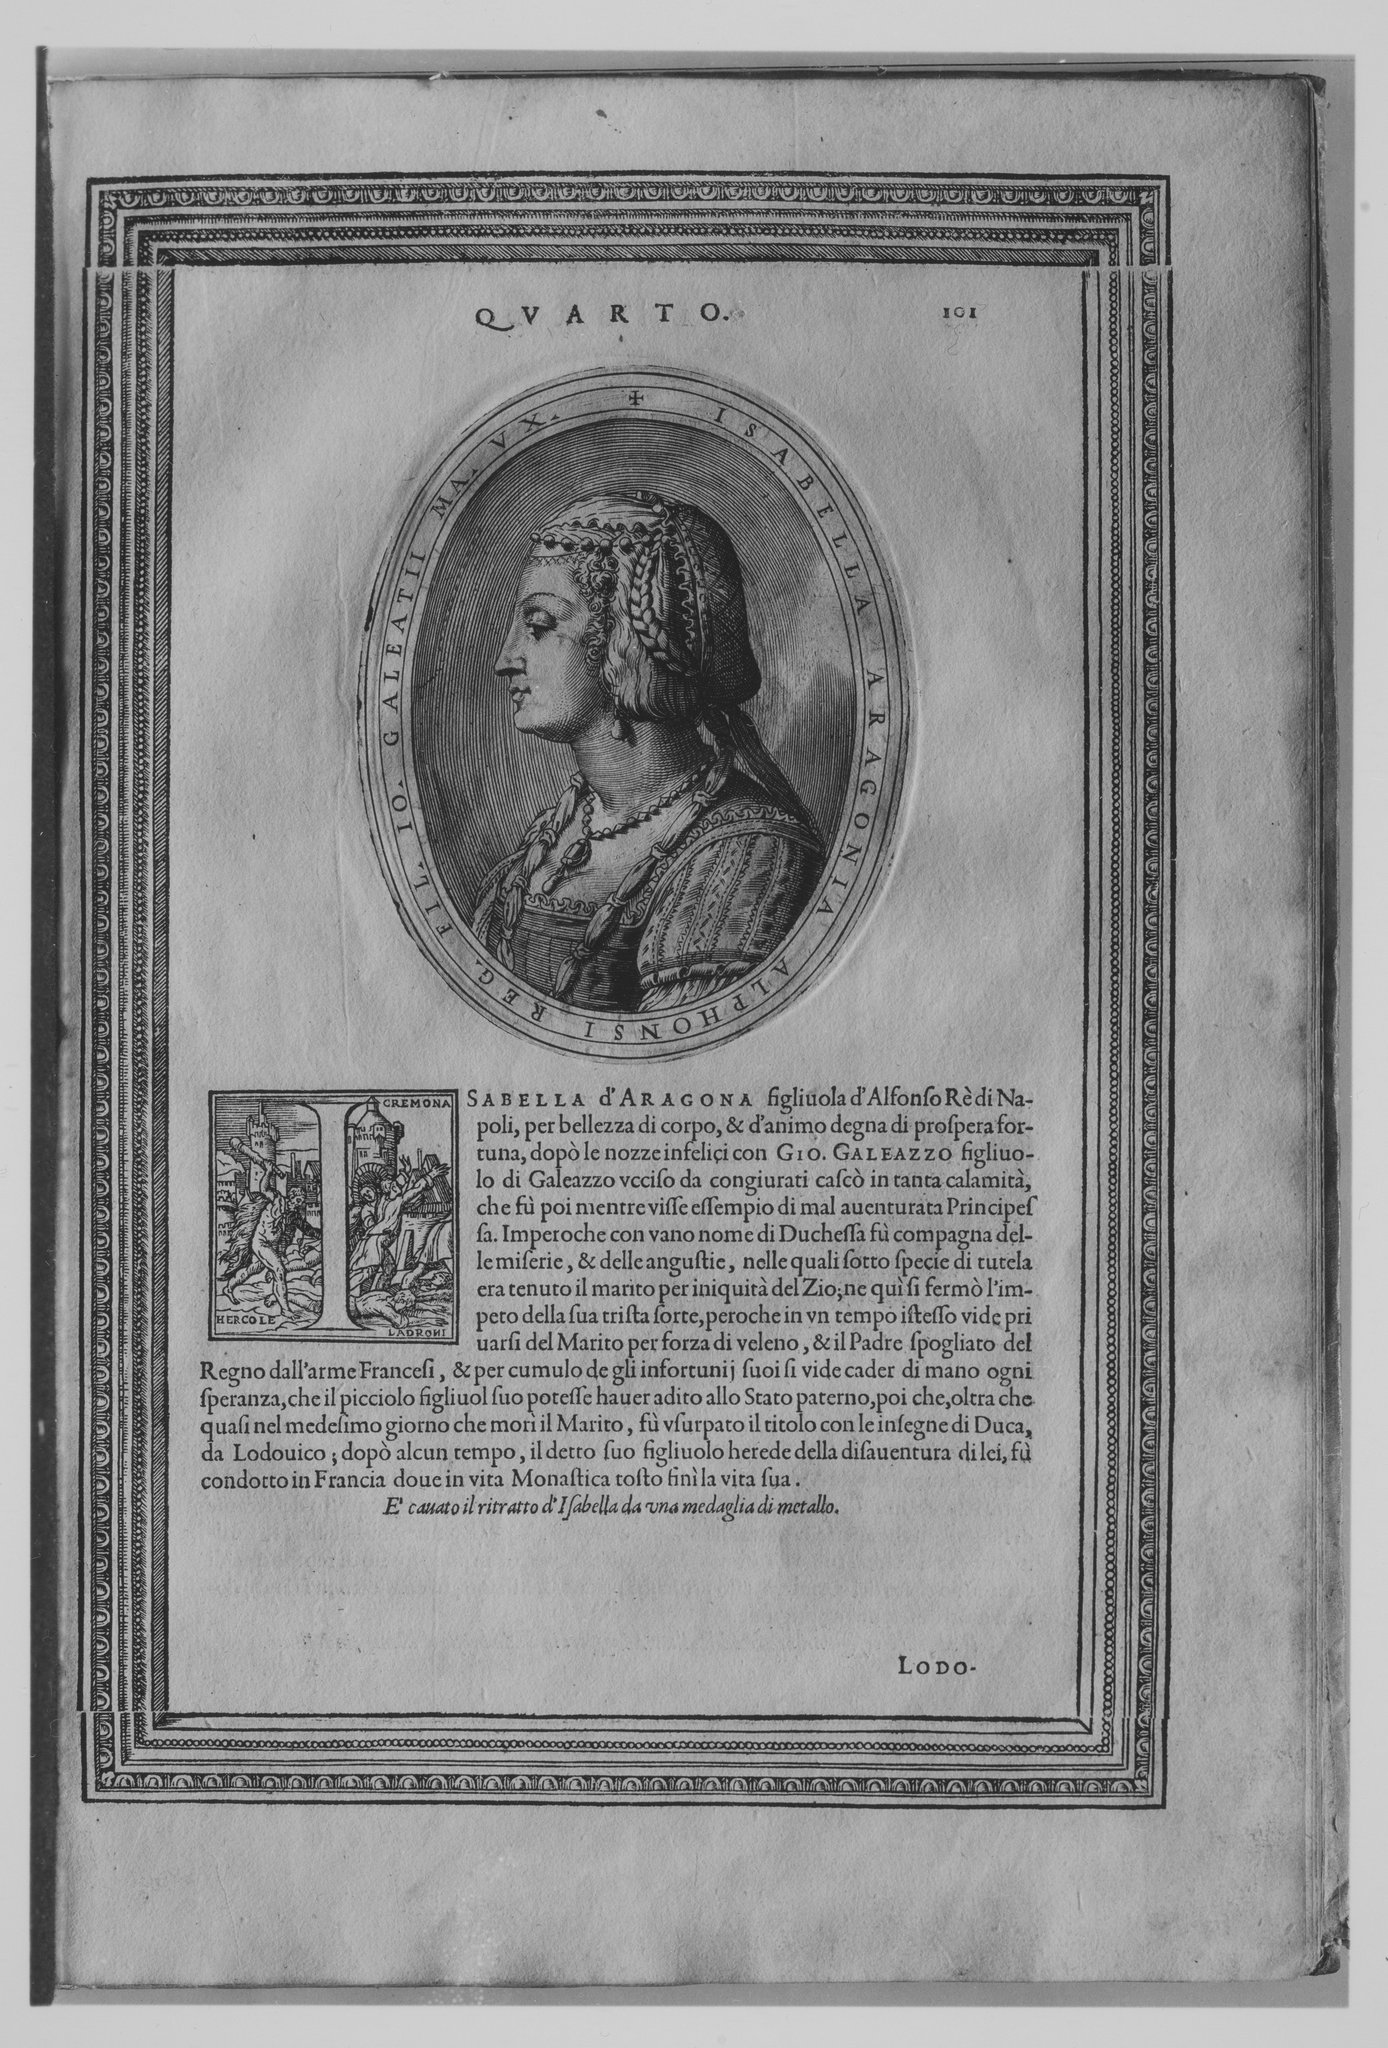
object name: book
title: Cremona Fedelissima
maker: antonio campo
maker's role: author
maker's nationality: italian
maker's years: 16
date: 1585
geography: italy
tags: profiles,women